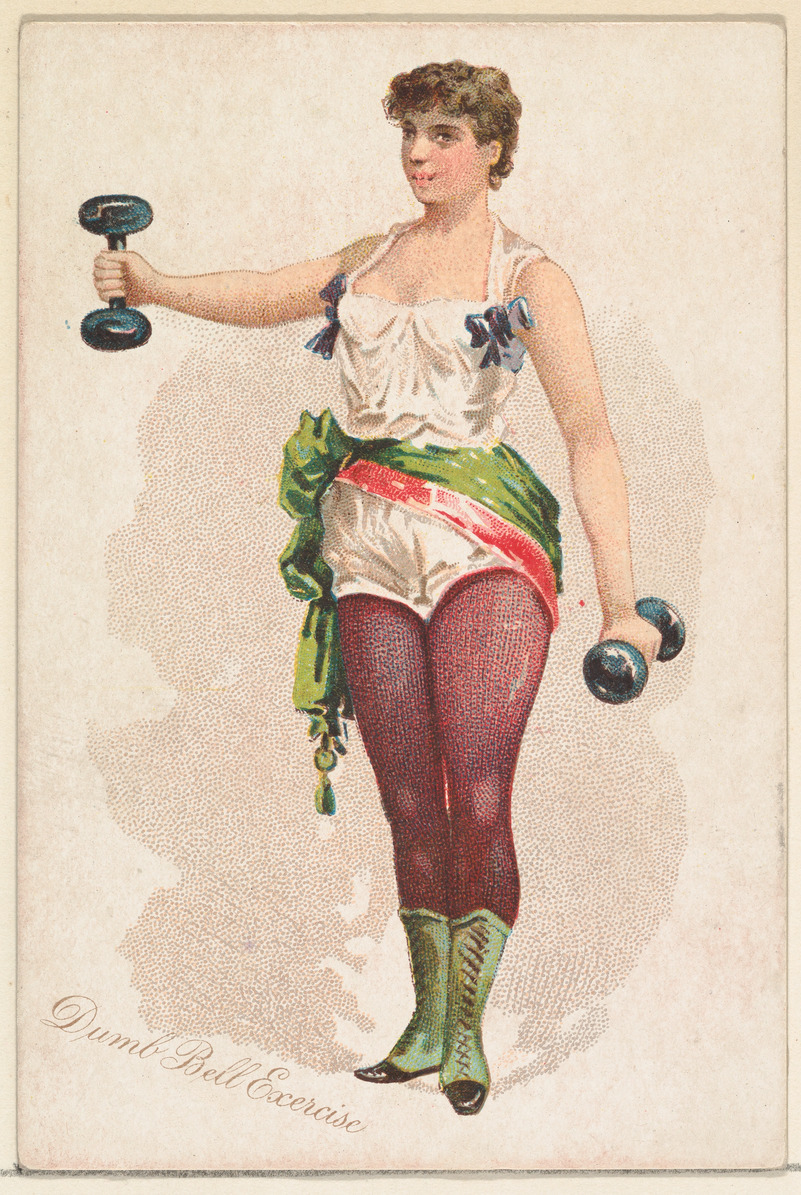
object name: print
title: Dumbbell Exercise, from the Pretty Athletes series (N196) issued by Wm. S. Kimball & Co.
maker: william s. kimball & company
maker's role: publisher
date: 1889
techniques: color lithograph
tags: women